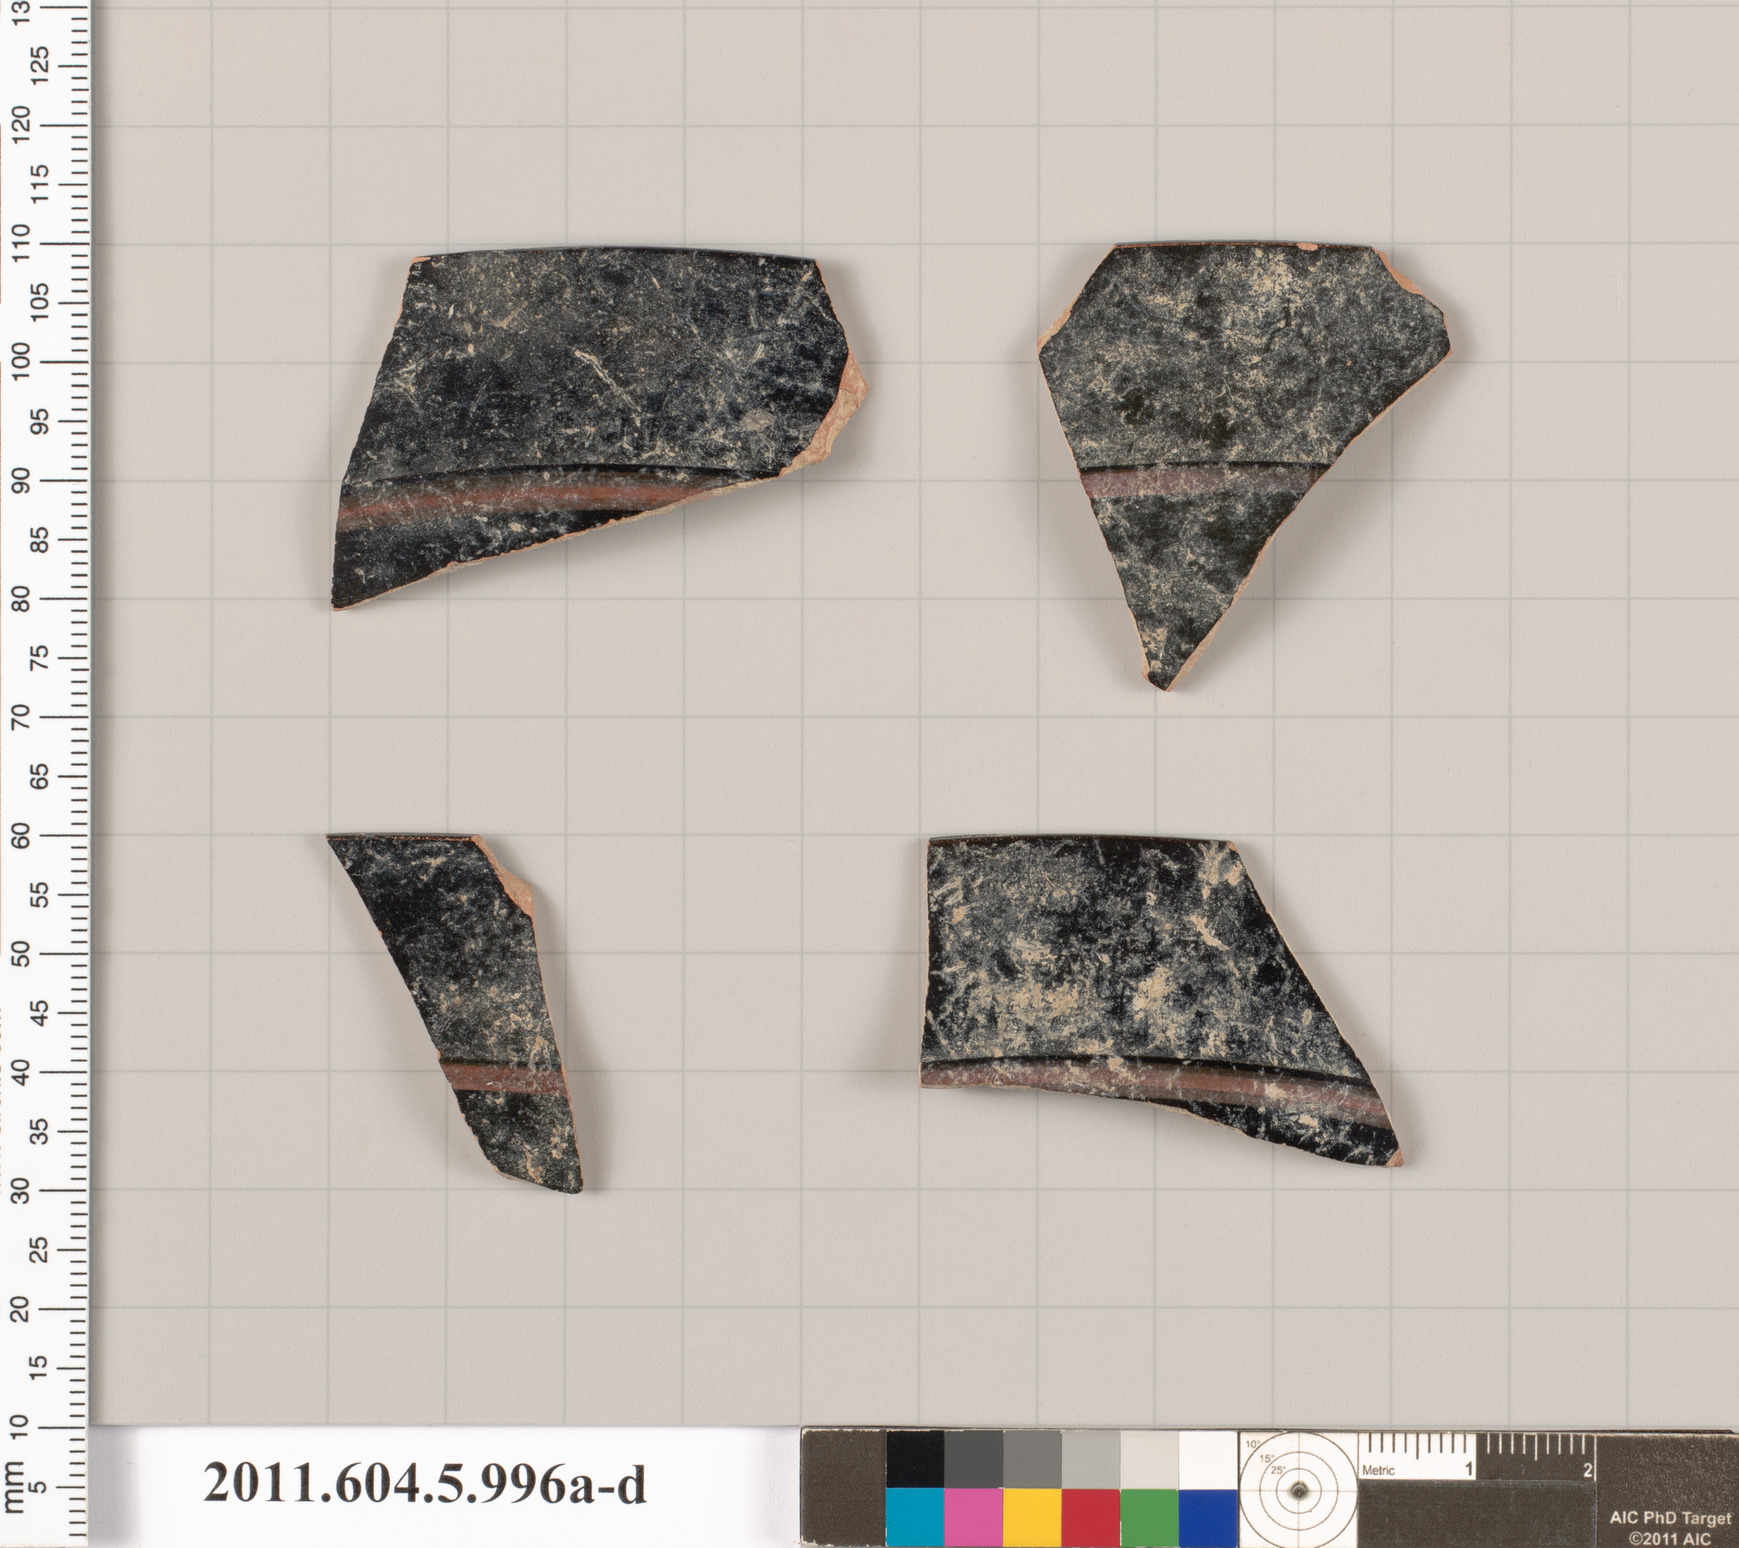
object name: kylix fragment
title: Terracotta rim fragments of a kylix (drinking cup)?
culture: greek, attic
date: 600-401 BCE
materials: terracotta